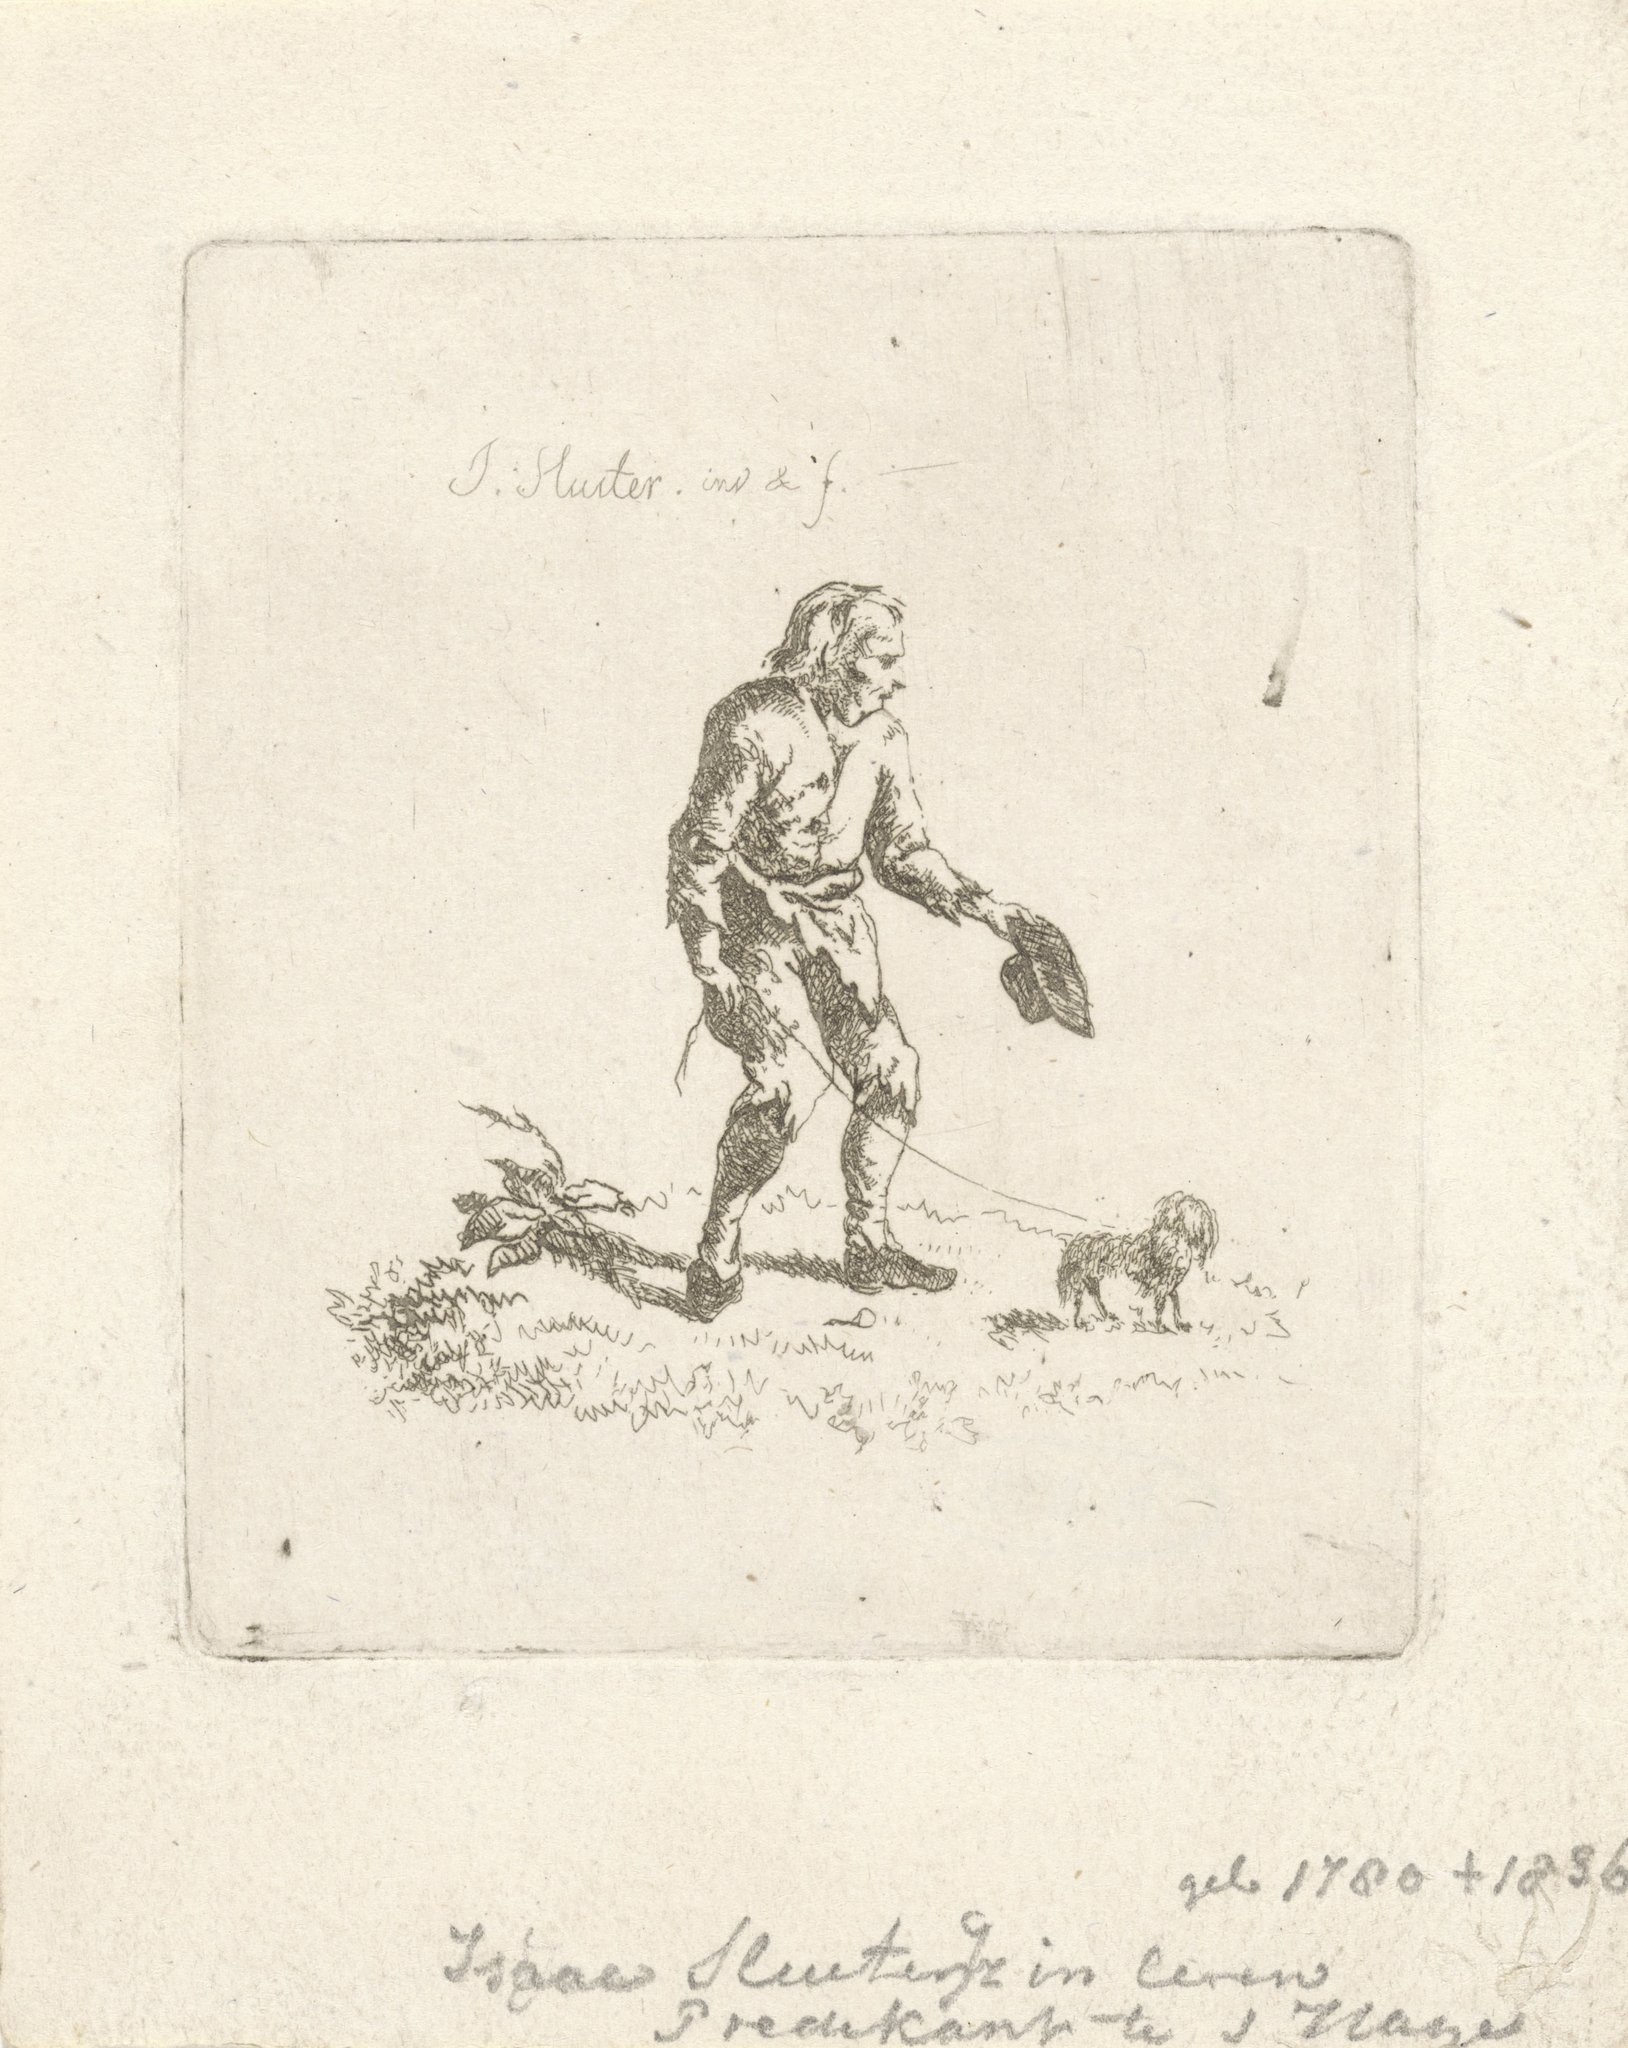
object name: print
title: Man met hond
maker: isaäc sluiter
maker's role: print maker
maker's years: 1779-1836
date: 1795-1836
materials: paper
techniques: etching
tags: walking the dog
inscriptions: collector's mark: Lugt 2228, inscription: ‘Isaac Sluyter Jz. in [Eerw.?] Predikant te 's Hage. geb. 1780 + 1836’